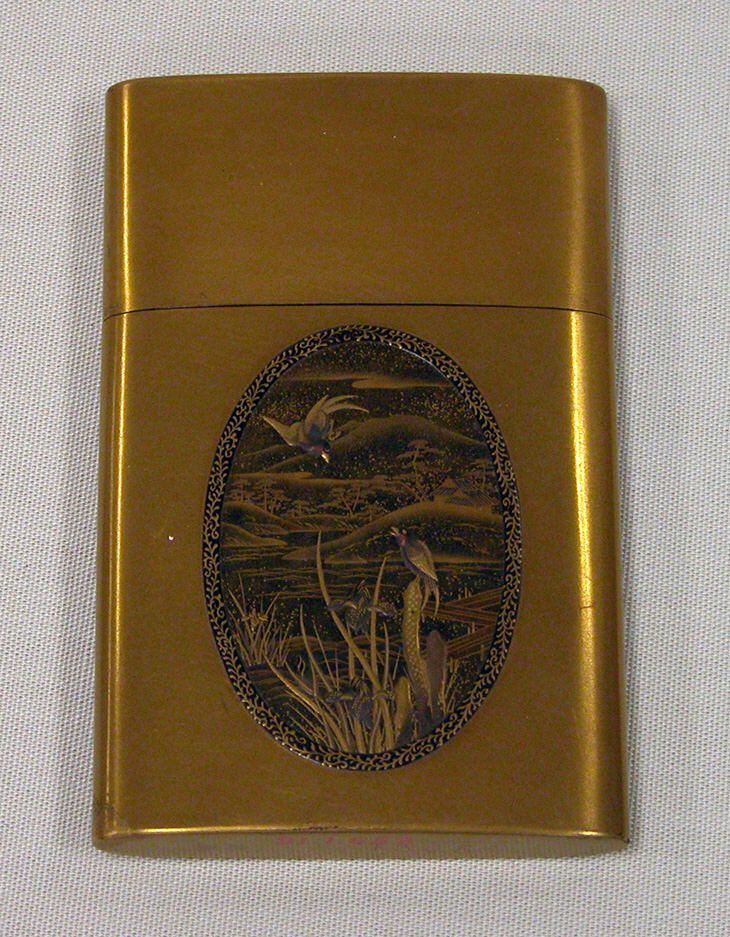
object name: card case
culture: japanese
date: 1850-1880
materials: gold, lacquer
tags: birds,plants